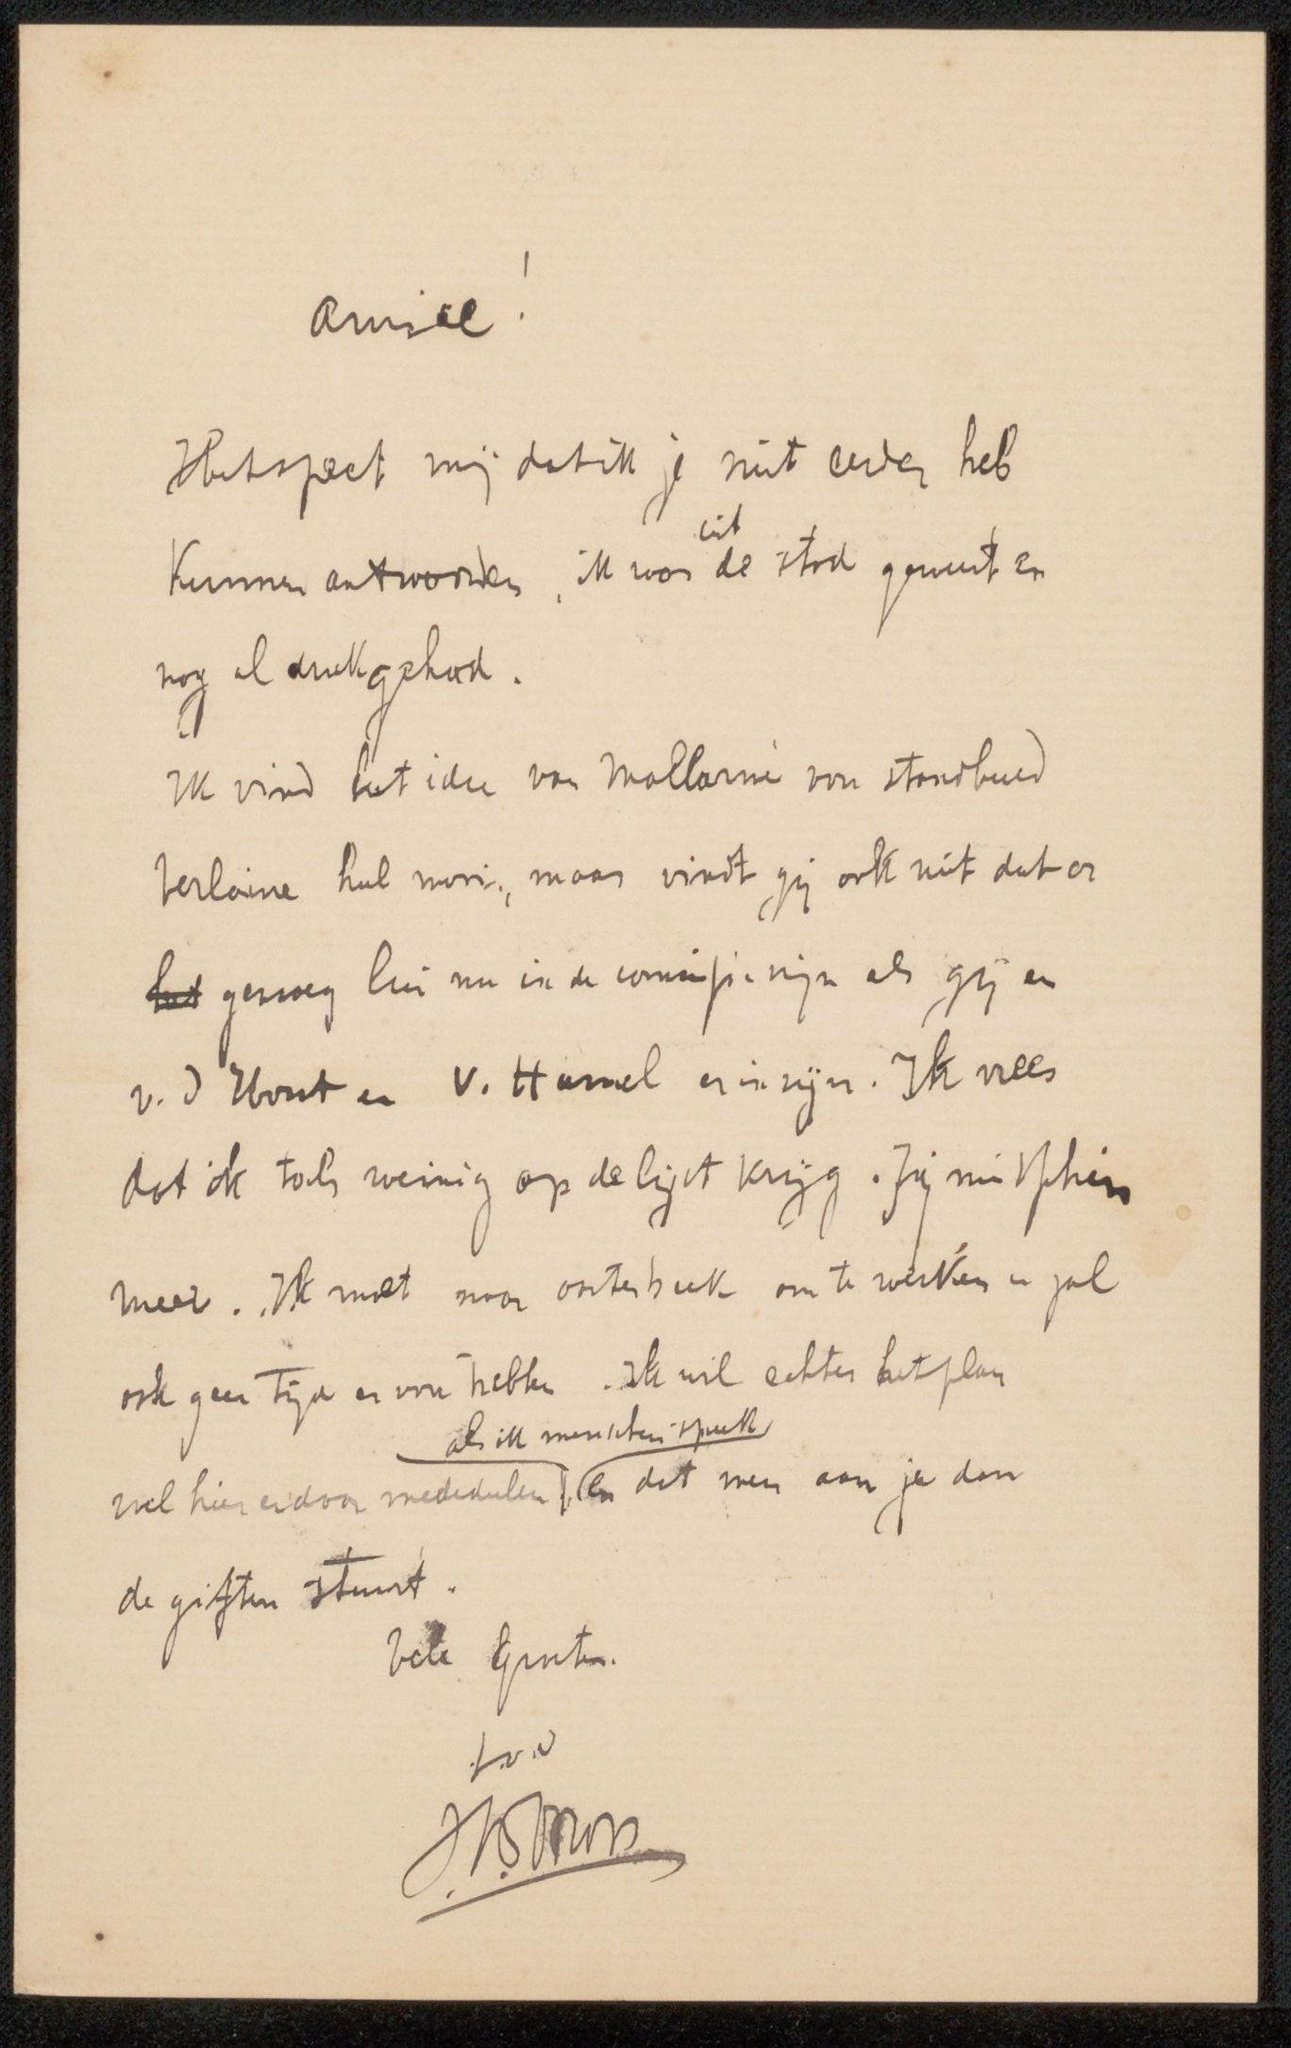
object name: letter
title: Brief aan Philip Zilcken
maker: jan toorop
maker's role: draughtsman, painter, print maker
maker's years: 1858-1928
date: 1868-1928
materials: ink, paper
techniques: pen, writing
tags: paul verlaine, paris, stéphane mallarmé, the hague, draughtsman, philip zilcken, sculpture, historical persons (portraits and scenes from the life)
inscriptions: collector's mark: ‘RPK’